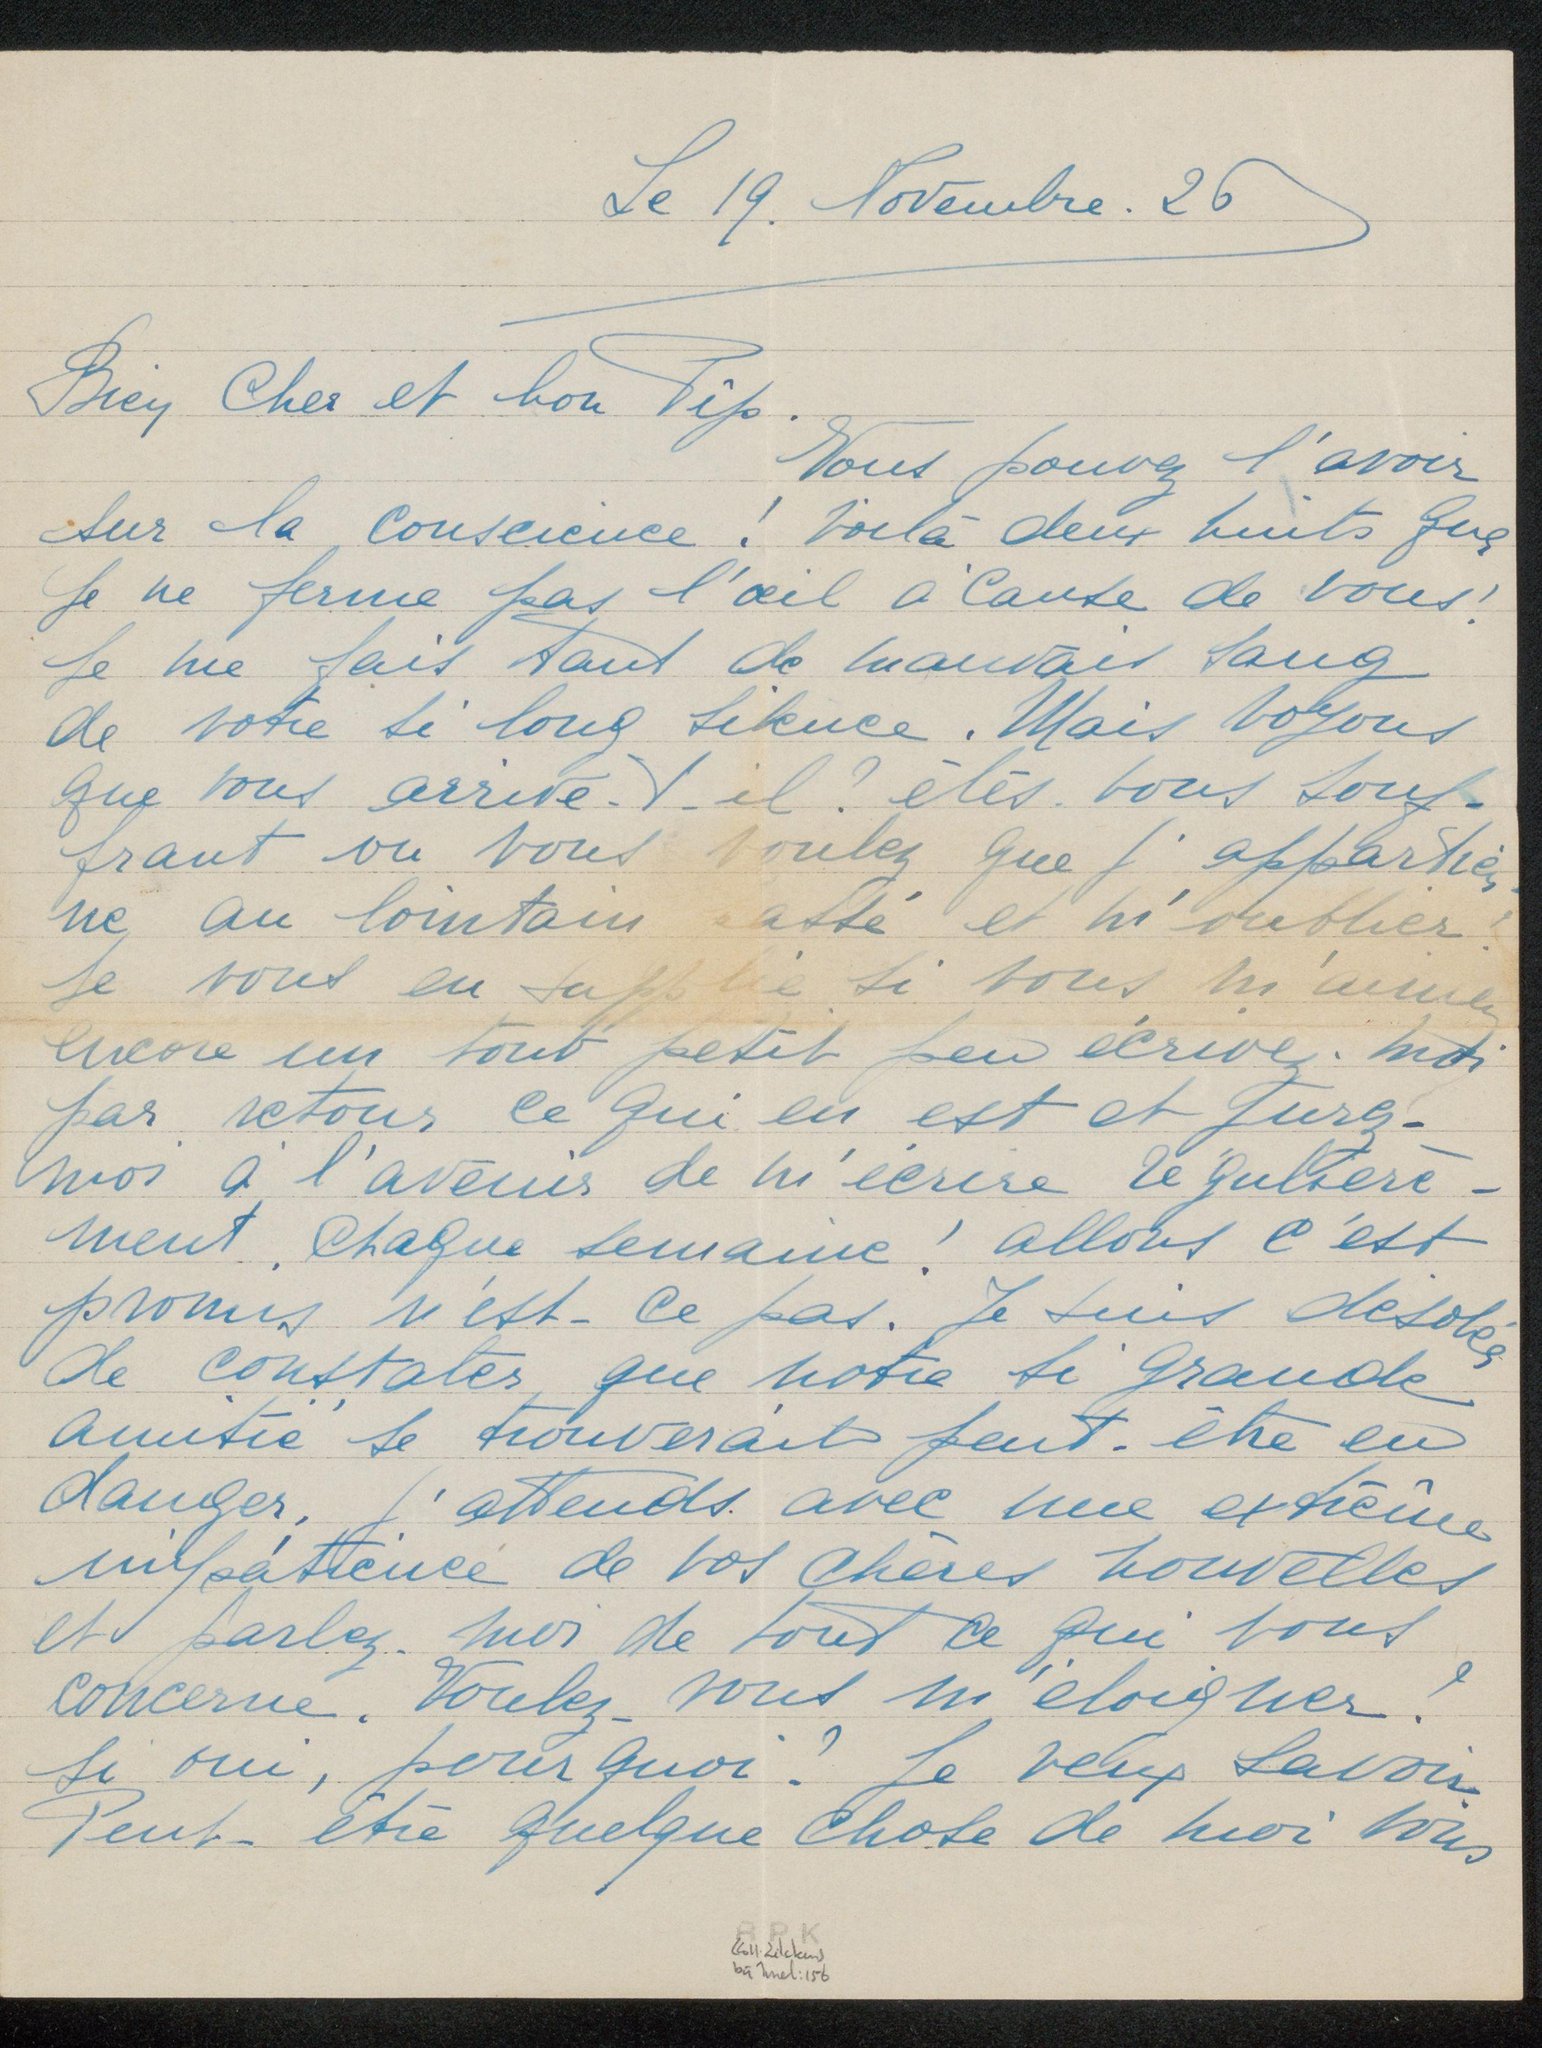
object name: letter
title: Brief aan Philip Zilcken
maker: rose imel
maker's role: draughtsman, painter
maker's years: 1901-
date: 1926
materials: ink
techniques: pen, writing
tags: the hague, painter, draughtsman, philip zilcken, drawing, painting (including book-illumination, miniature-painting), brussels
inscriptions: collector's mark: ‘RPK’